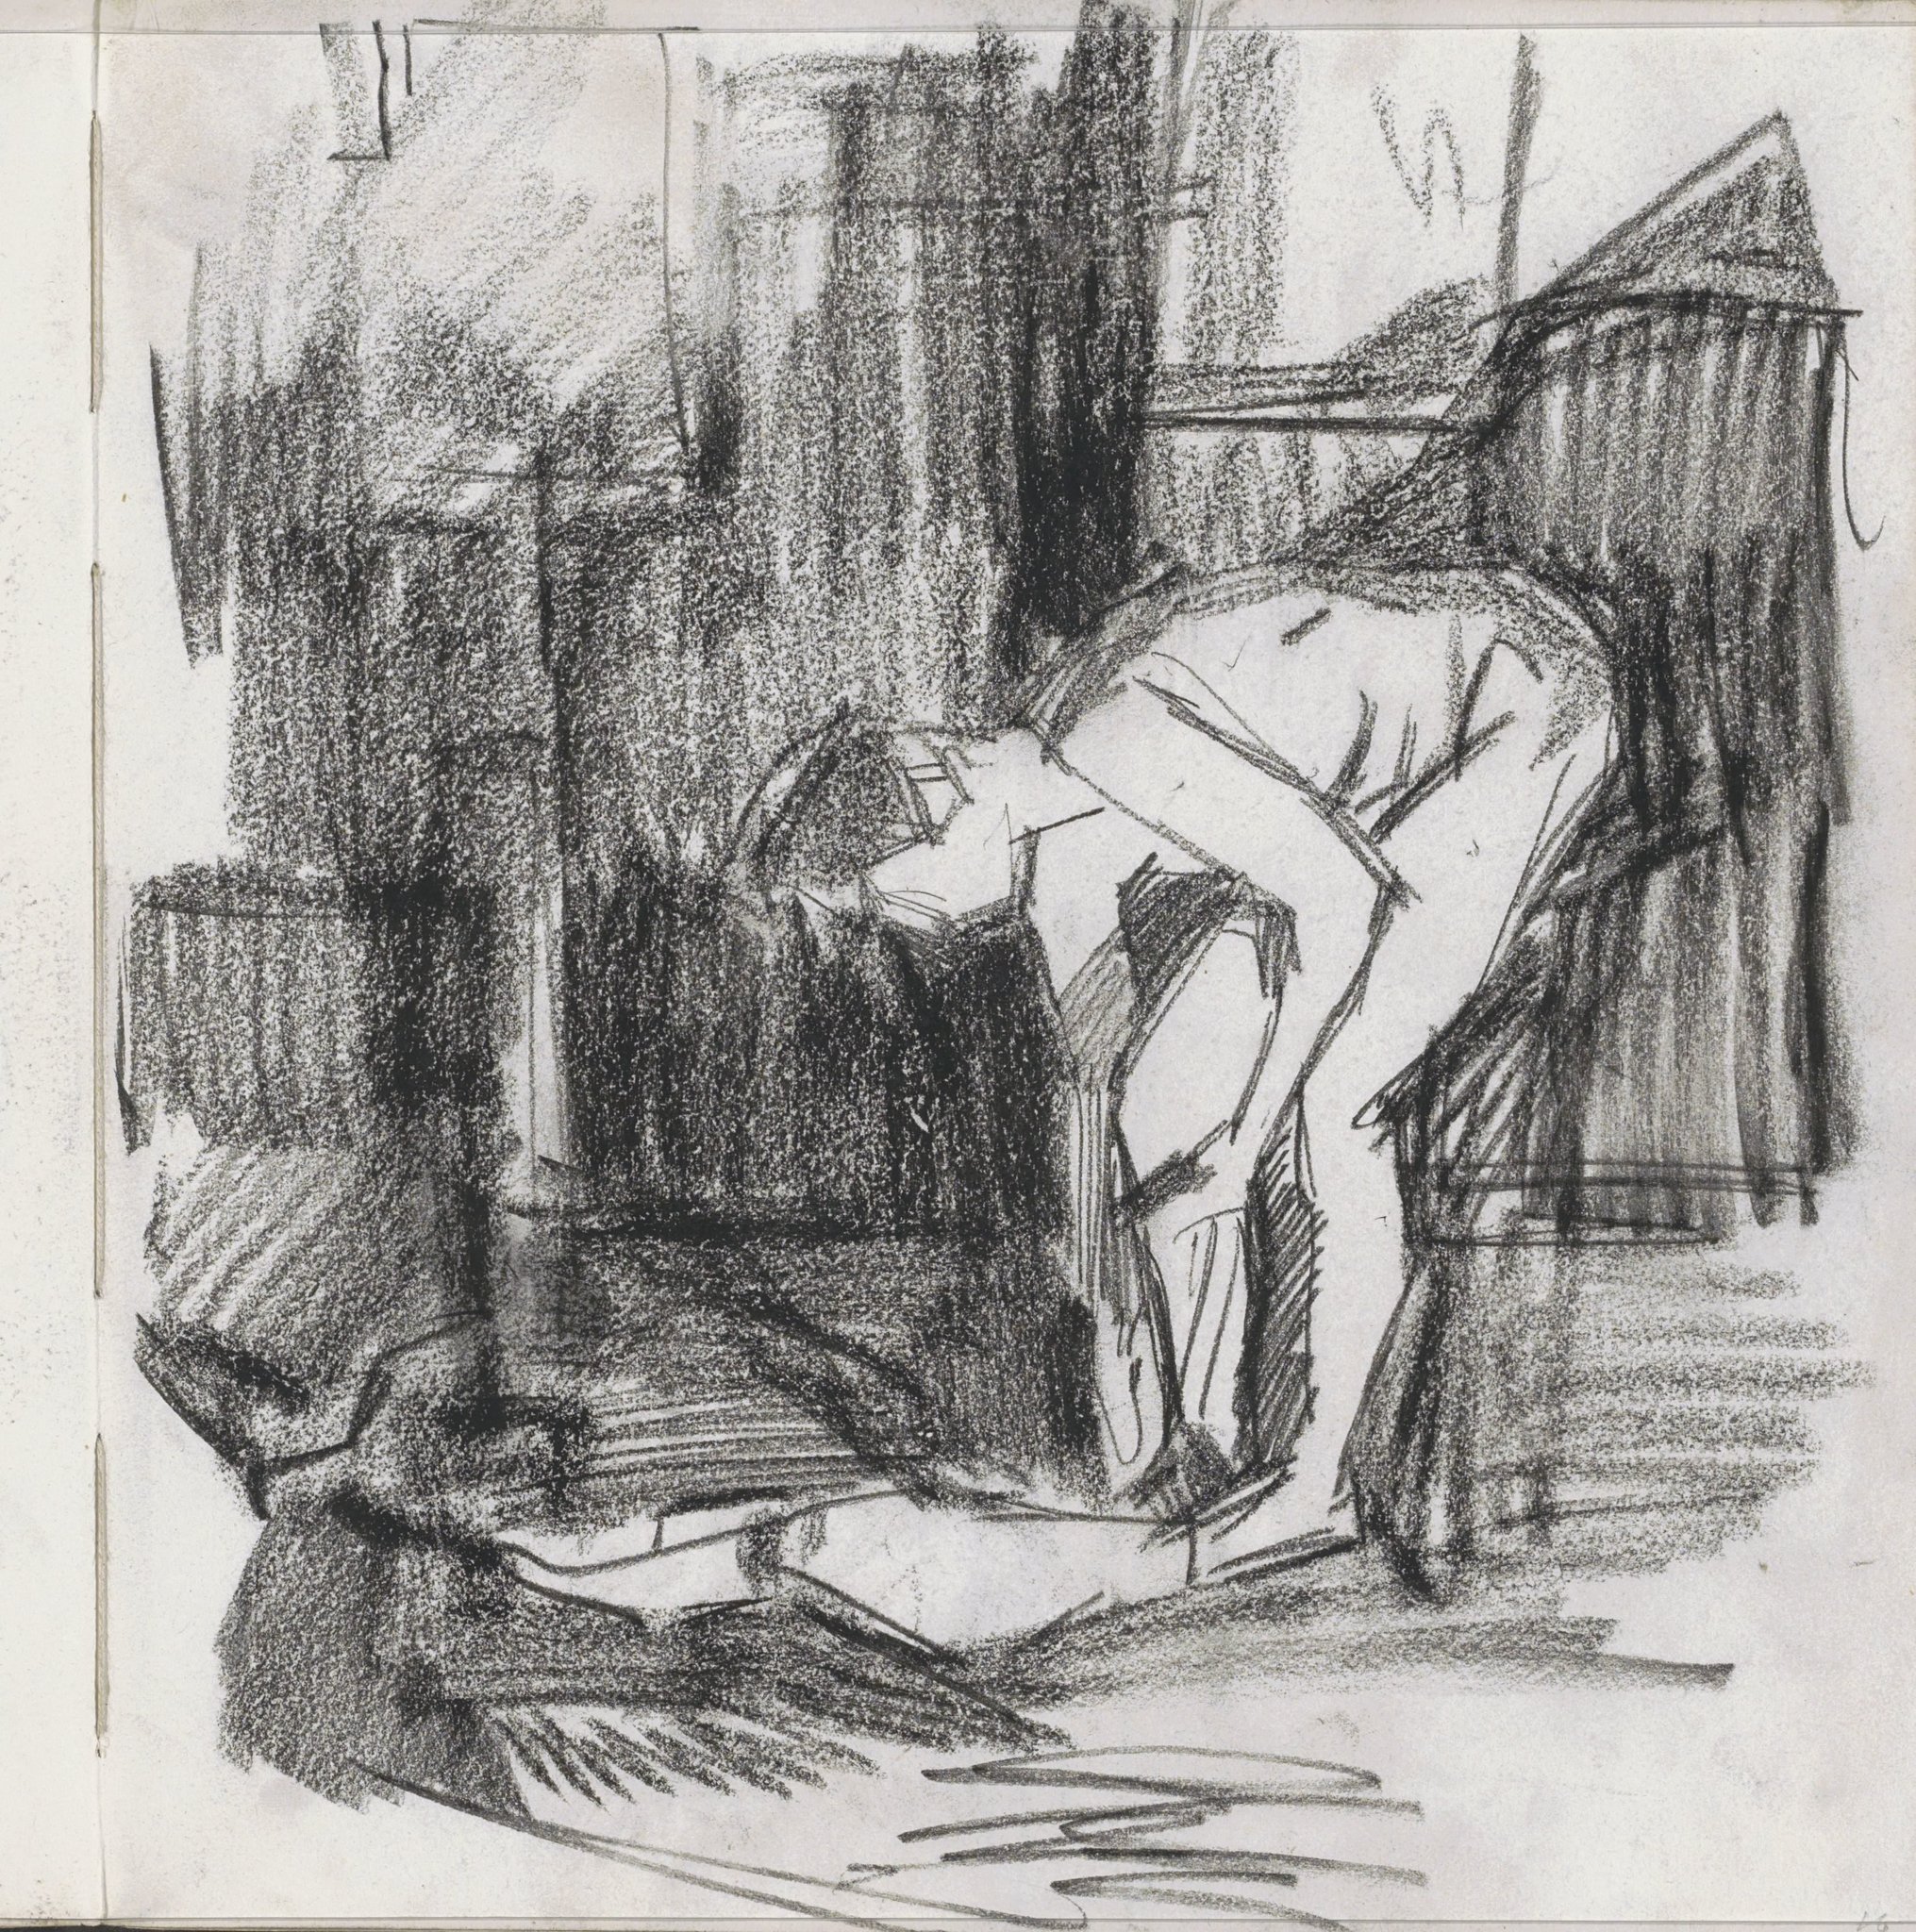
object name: sketchbook leaf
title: Bukkend vrouwelijk naakt in een interieur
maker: isaac israels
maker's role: draughtsman, painter, print maker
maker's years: 1865-1934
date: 1875-1934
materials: chalk, paper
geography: the hague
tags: bending figure - aa - female human figure (+ sideview, profile), interior of the house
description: Ze raapt mogelijk iets op van de grond. Blad 16 recto uit schetsboek IX met 28 bladen.